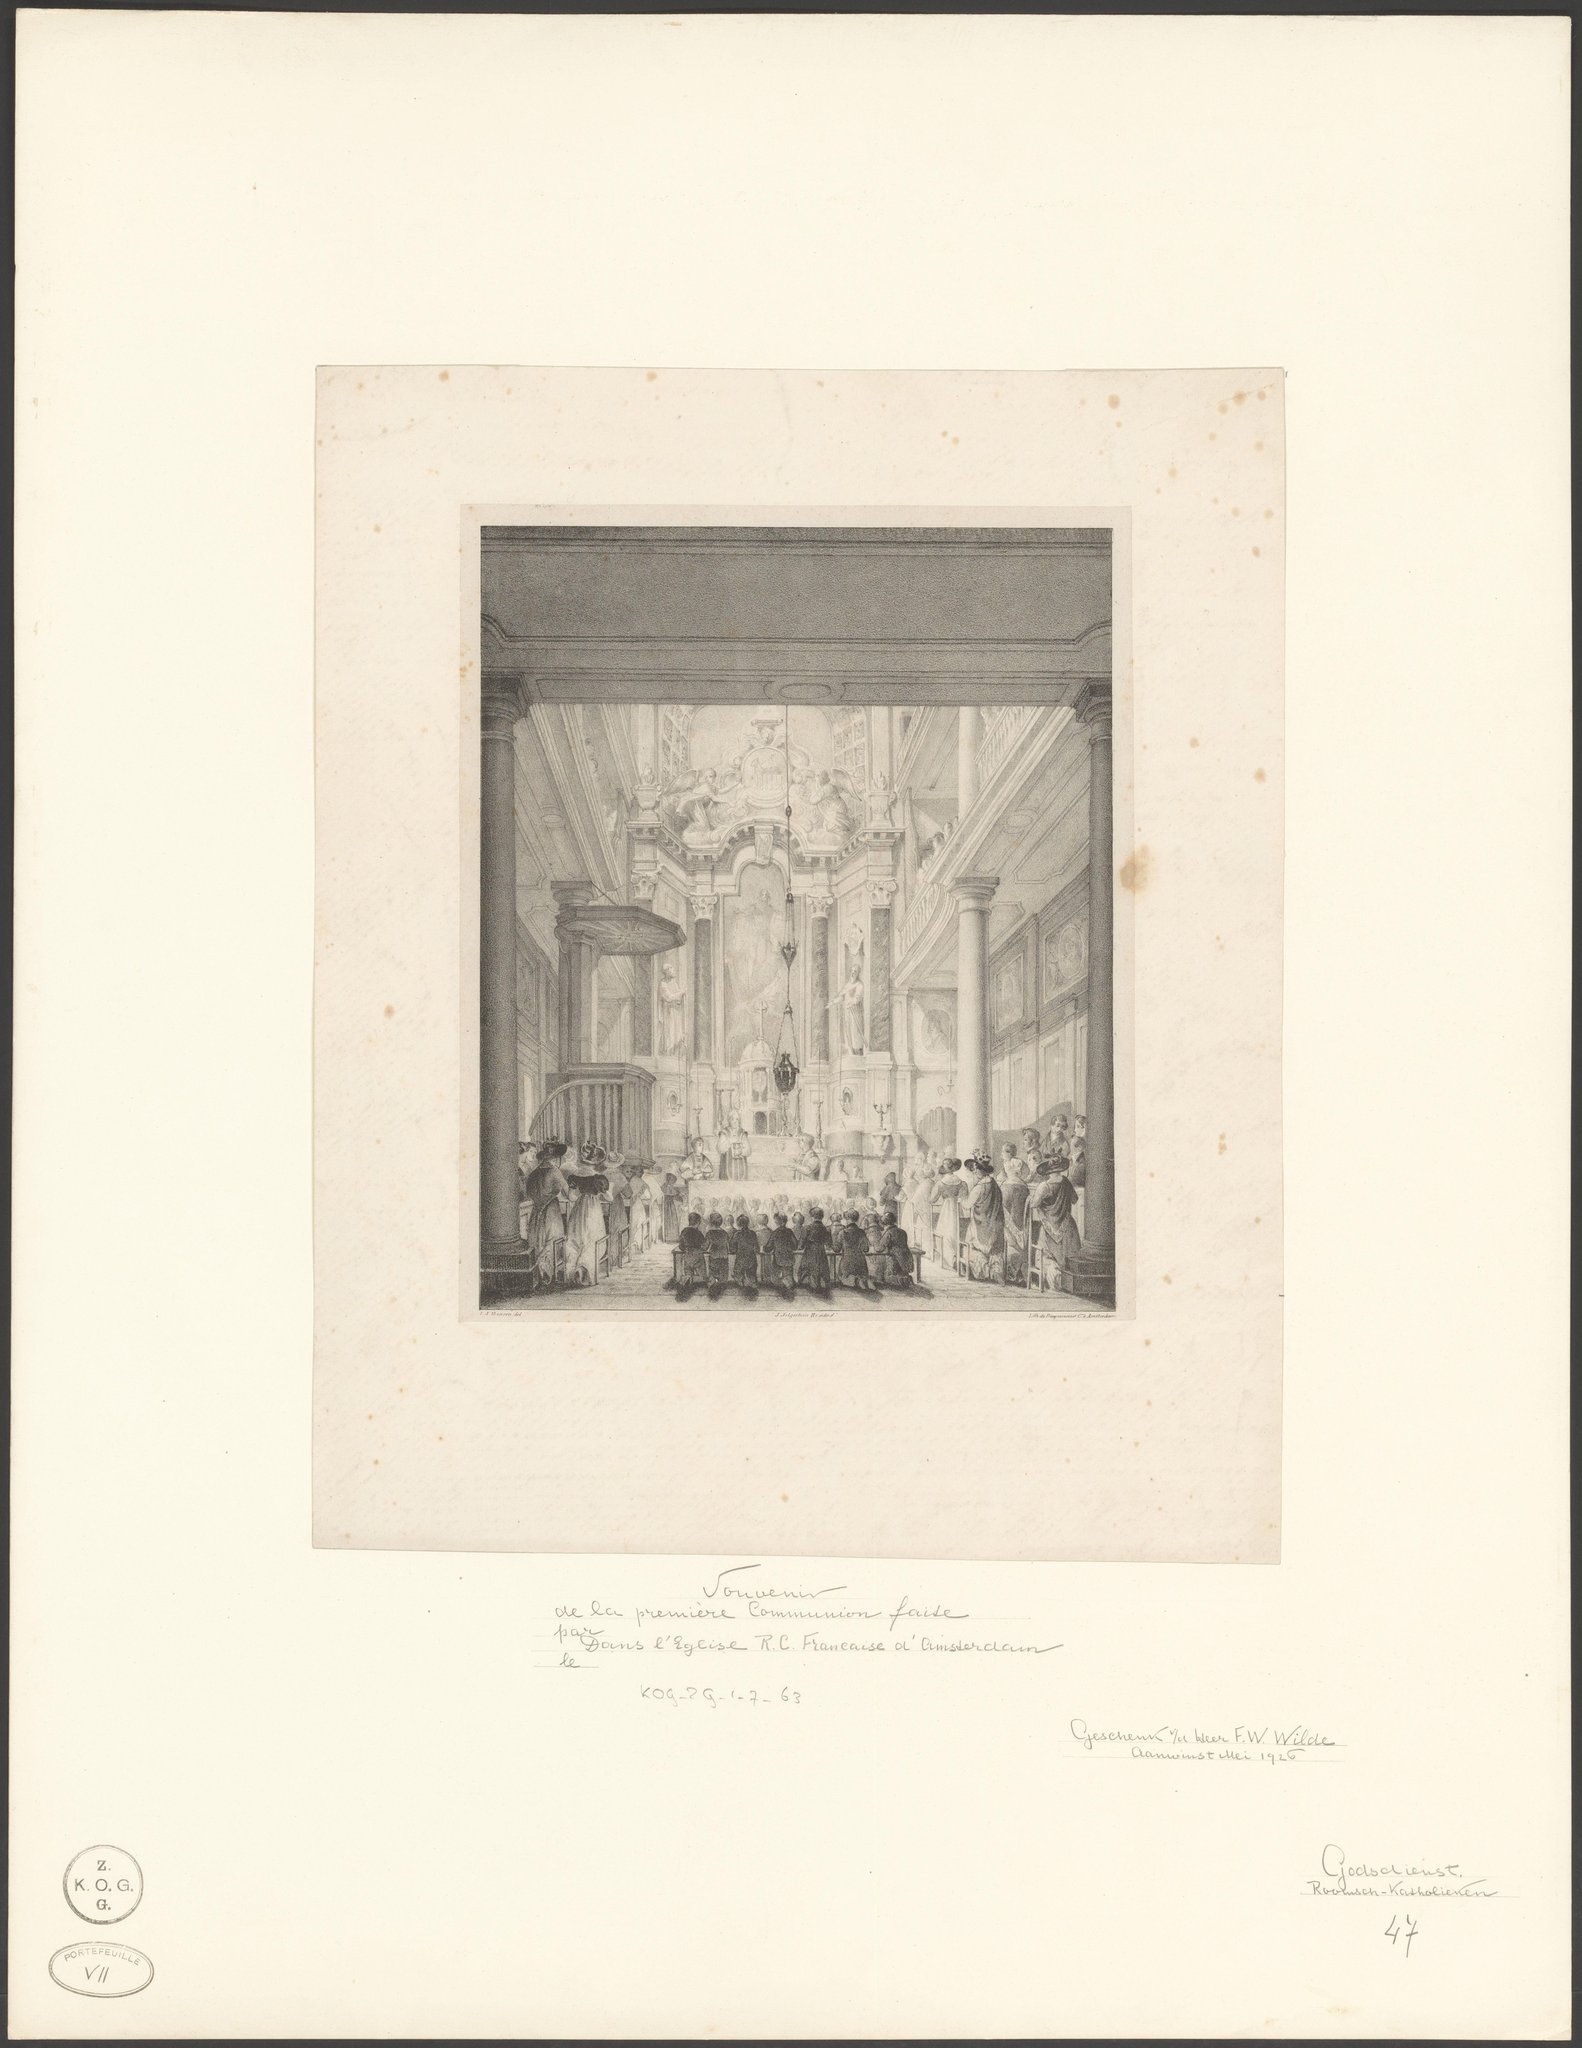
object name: print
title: Franse kerk op de Boommarkt te Amsterdam, ca. 1830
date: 1830-1835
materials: paper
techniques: lithograph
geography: amsterdam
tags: interior of church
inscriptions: collector's mark: Lugt 1641, stamp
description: Kerkinterieur waarin kinderen worden toegelaten tot de eerste heilige communie in de rooms-katholiek Franse kerk op de Boommarkt, de huidige Nieuwezijds Voorburgwal, te Amsterdam, ca. 1830-1835. Onderwerpsrubrieken binnen de Atlas Zeden en Gewoonten: Godsdienst, Roomsch-Katholieken, Processies, Herinneringen.